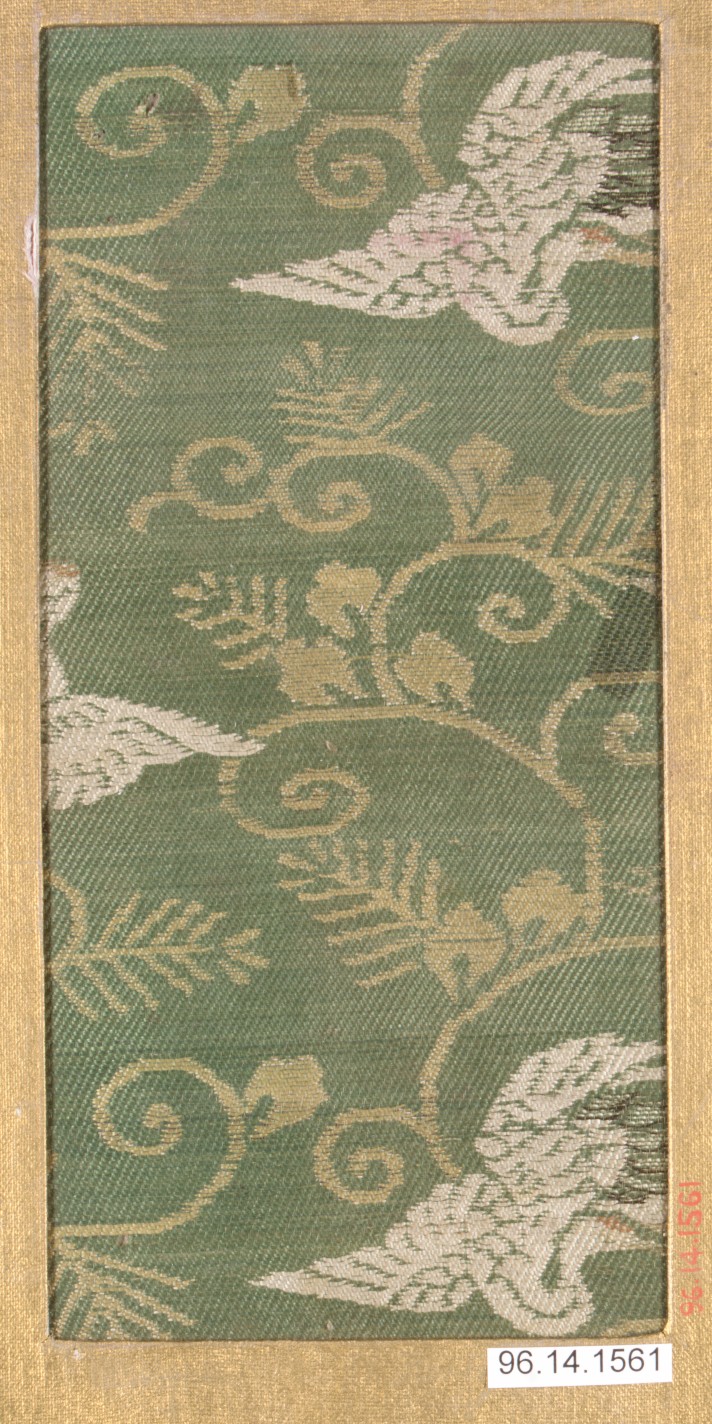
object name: piece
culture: japanese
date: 1701-1900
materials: silk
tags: leaves